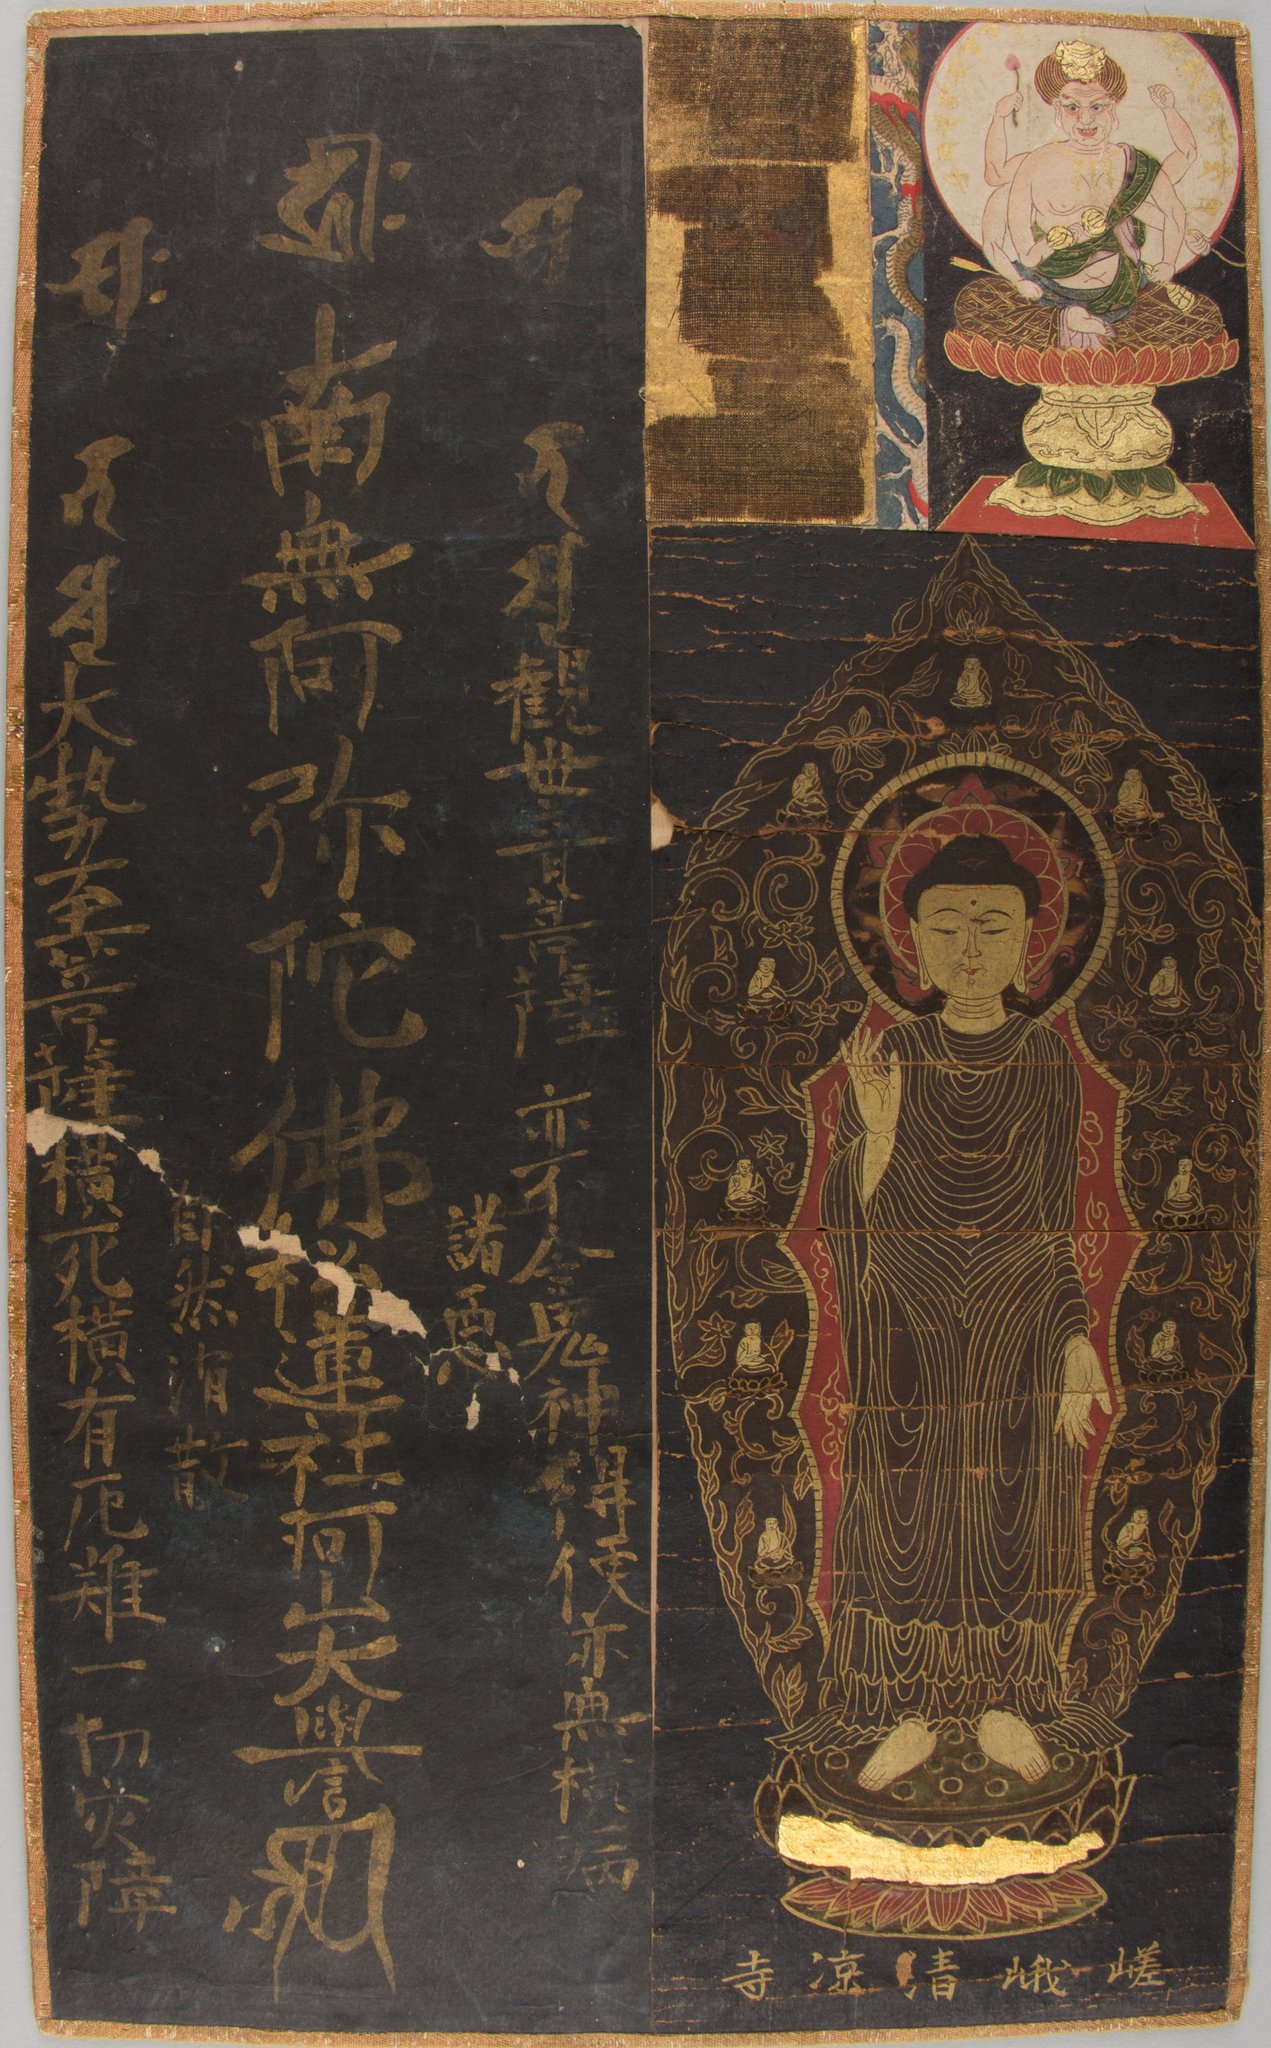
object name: book fragment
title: Page of a Pilgrim’s Visiting Album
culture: japanese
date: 1667-1800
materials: gold, ink, paper, textile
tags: buddhism